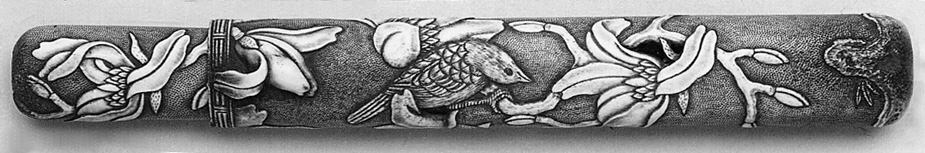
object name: pipe case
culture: japanese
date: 1801-1900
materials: bone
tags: birds